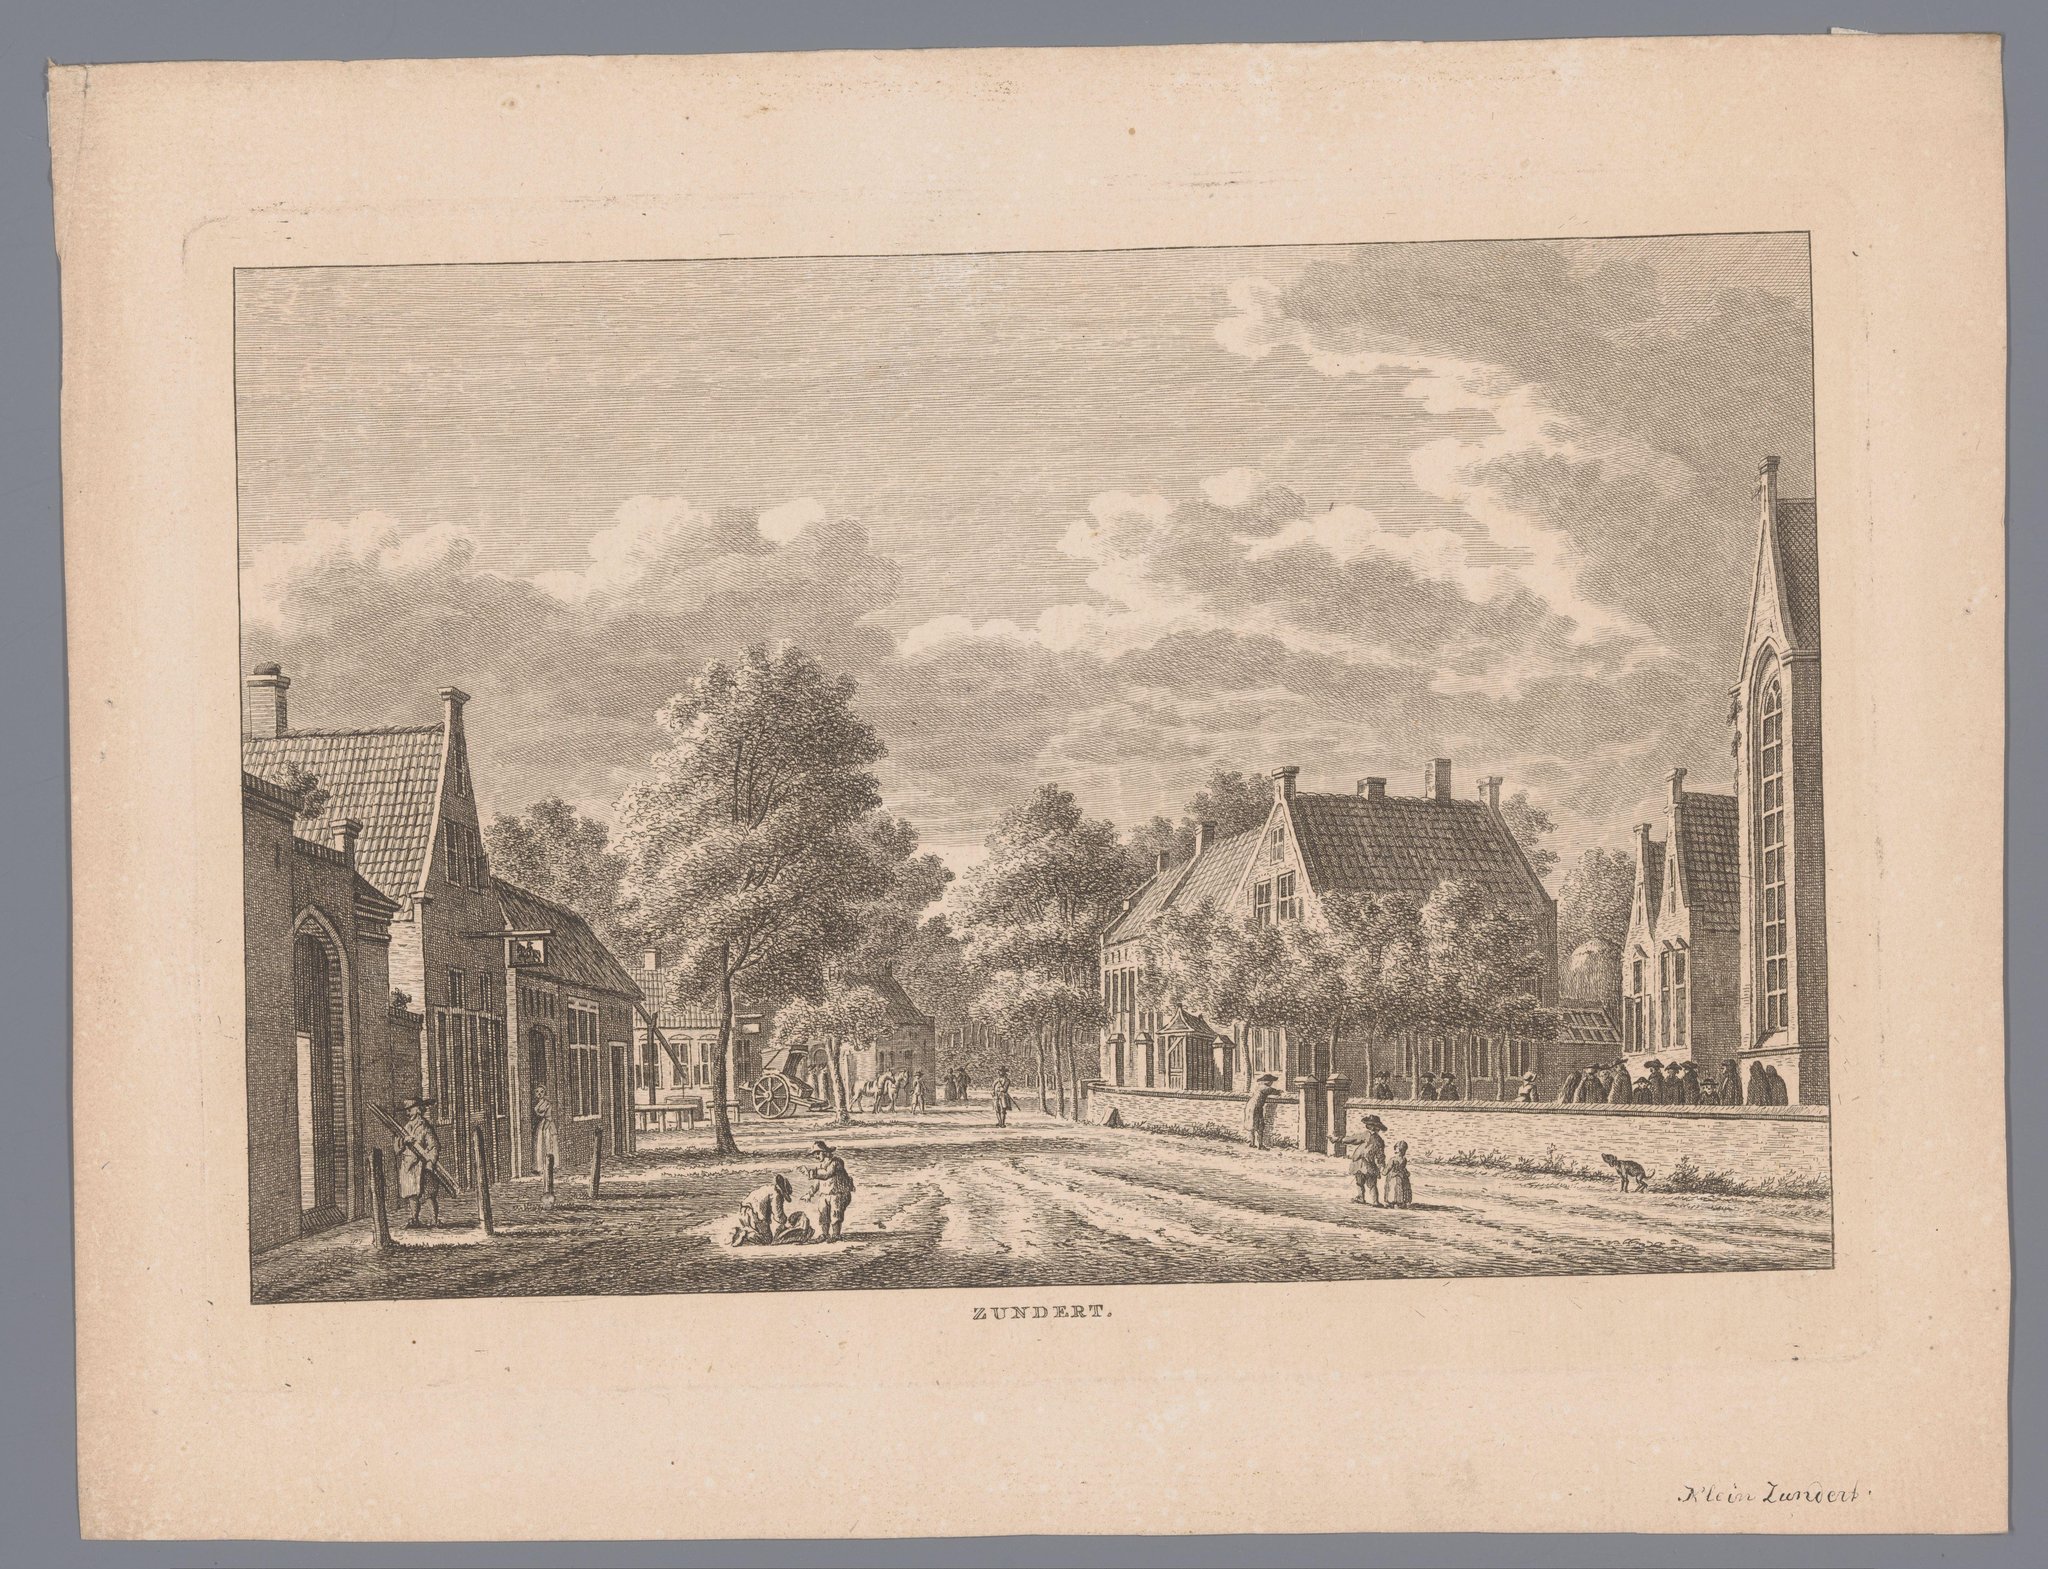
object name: print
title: Zundert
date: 1786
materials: paper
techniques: engraving, etching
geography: amsterdam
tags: village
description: Prent uit: Bulthuis, Jan. Vaderlandsche gezichten of afbeeldingen (...). 3 dln. Amsterdam: Hendrik Gartman, 1786, dl. 3.